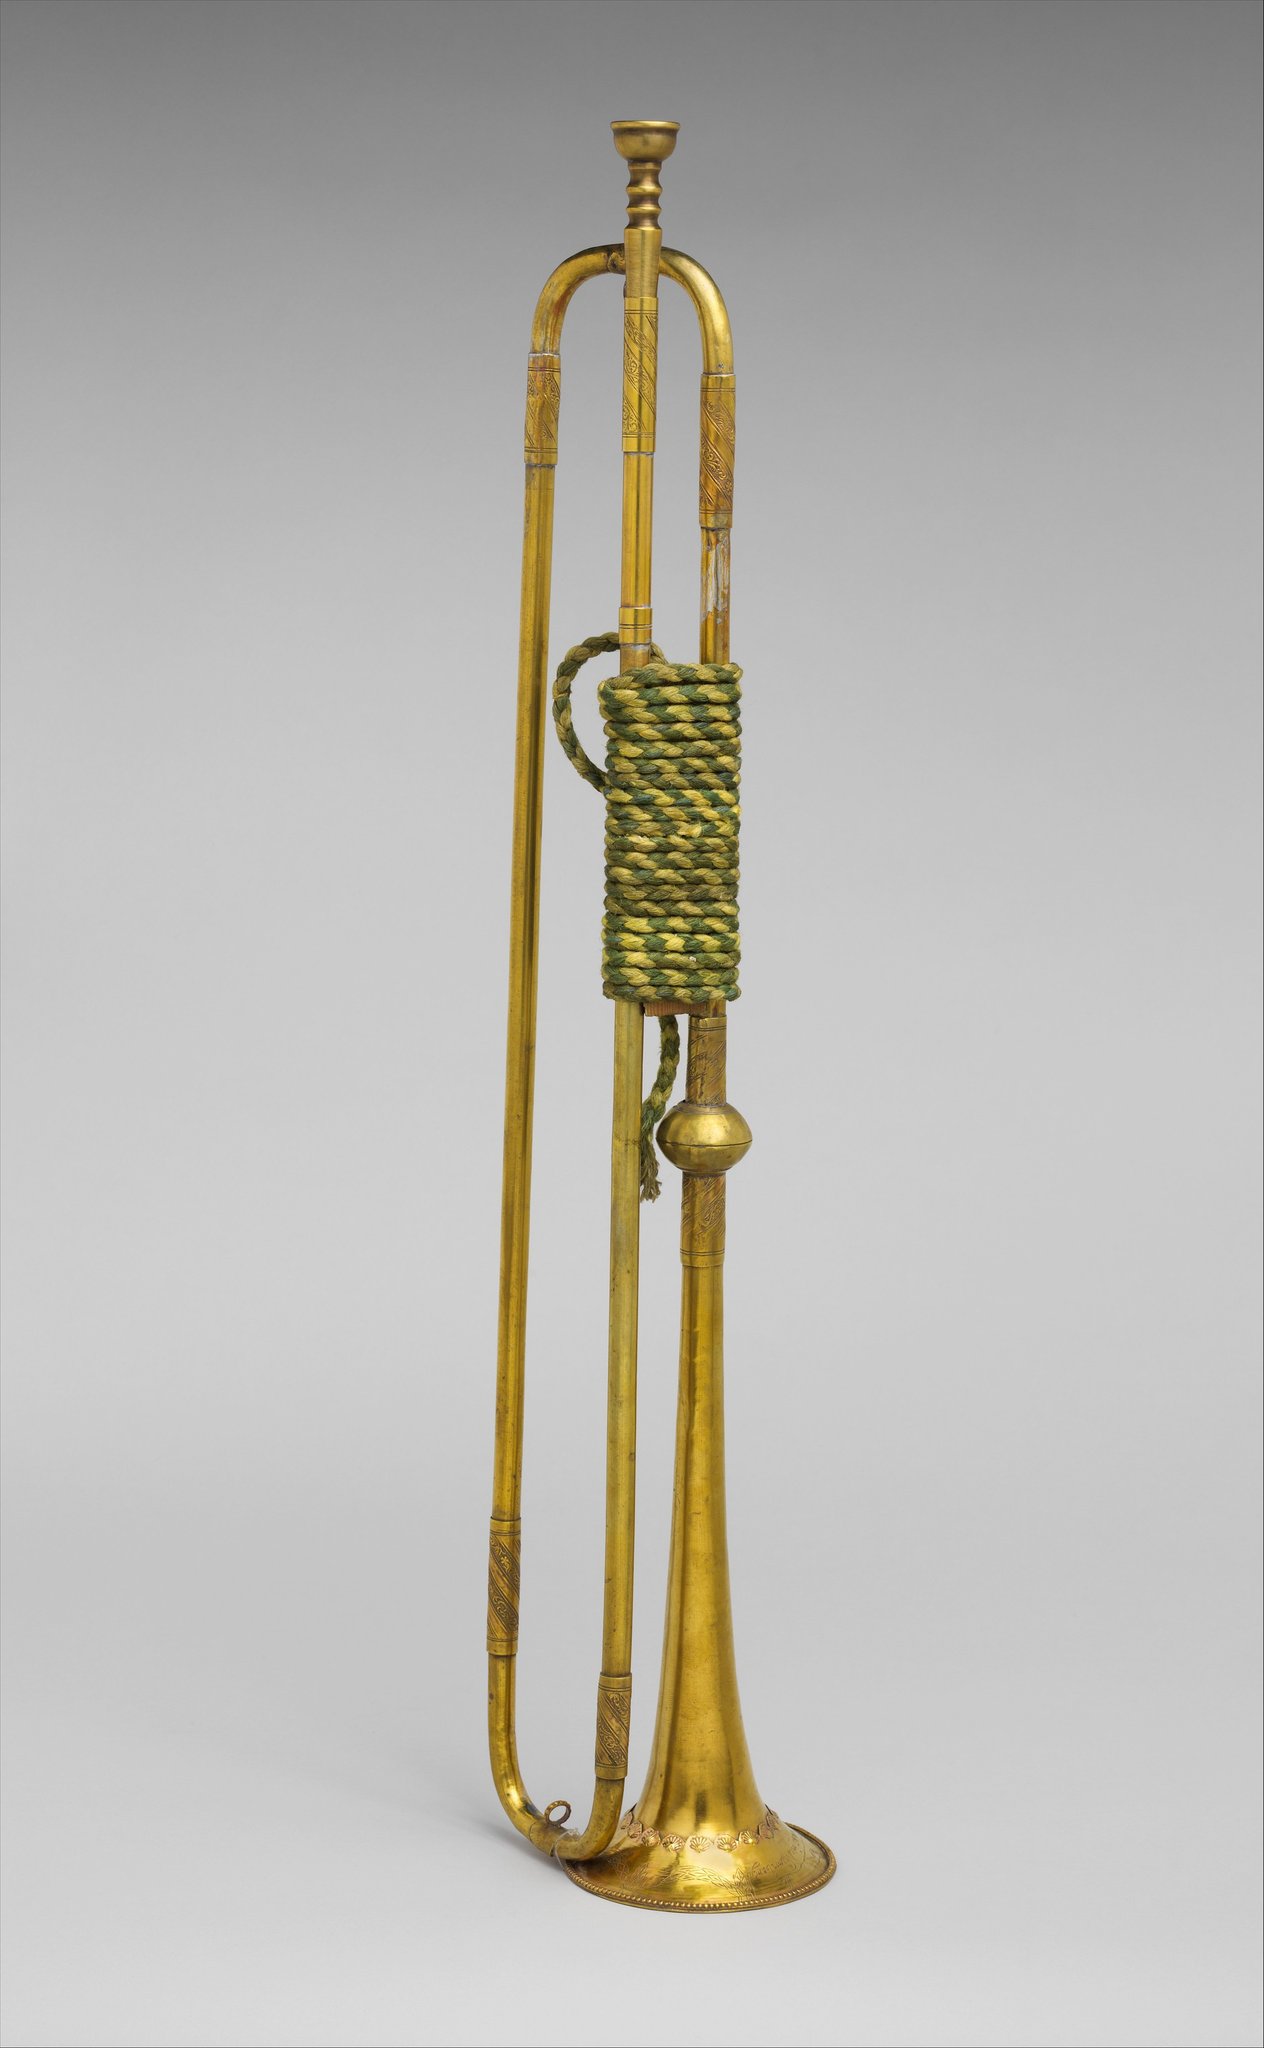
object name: natural trumpet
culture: german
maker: johann wilhelm haas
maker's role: maker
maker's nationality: german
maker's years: 1649-1723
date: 1667-1700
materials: brass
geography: germany